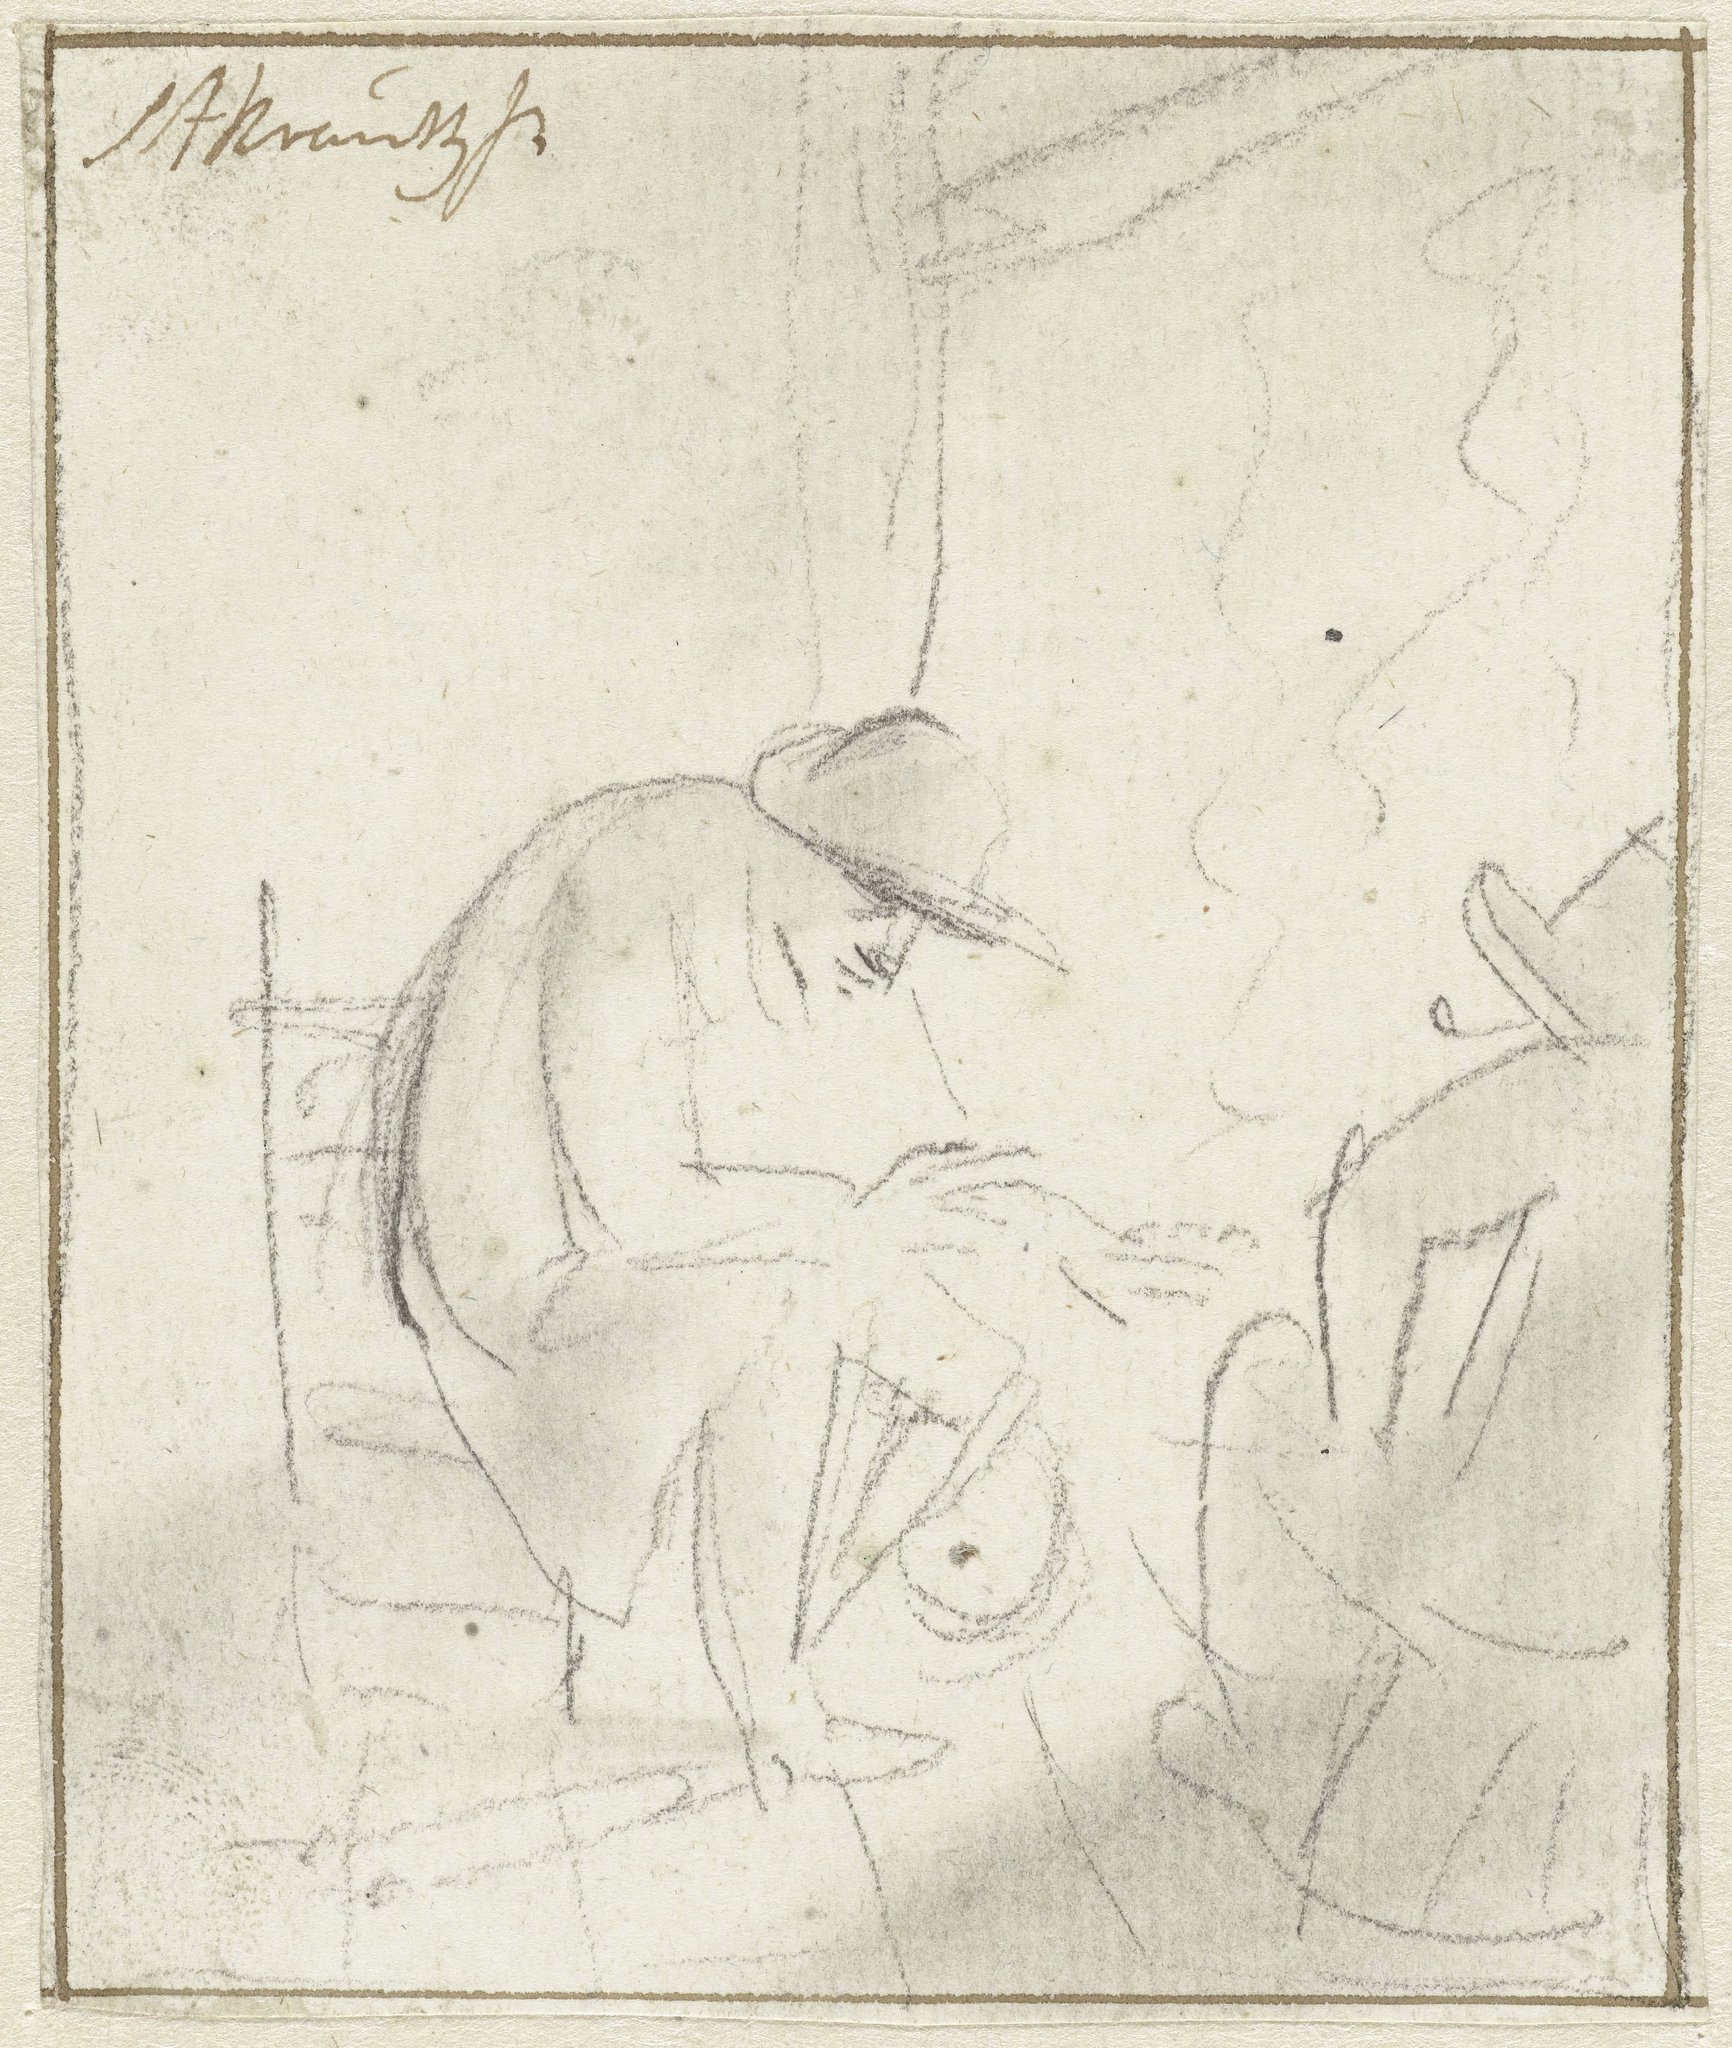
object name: drawing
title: Twee mannen, zittend bij een schouw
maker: simon andreas krausz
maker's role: draughtsman, print maker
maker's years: 1760-1825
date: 1770-1825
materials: chalk, paper